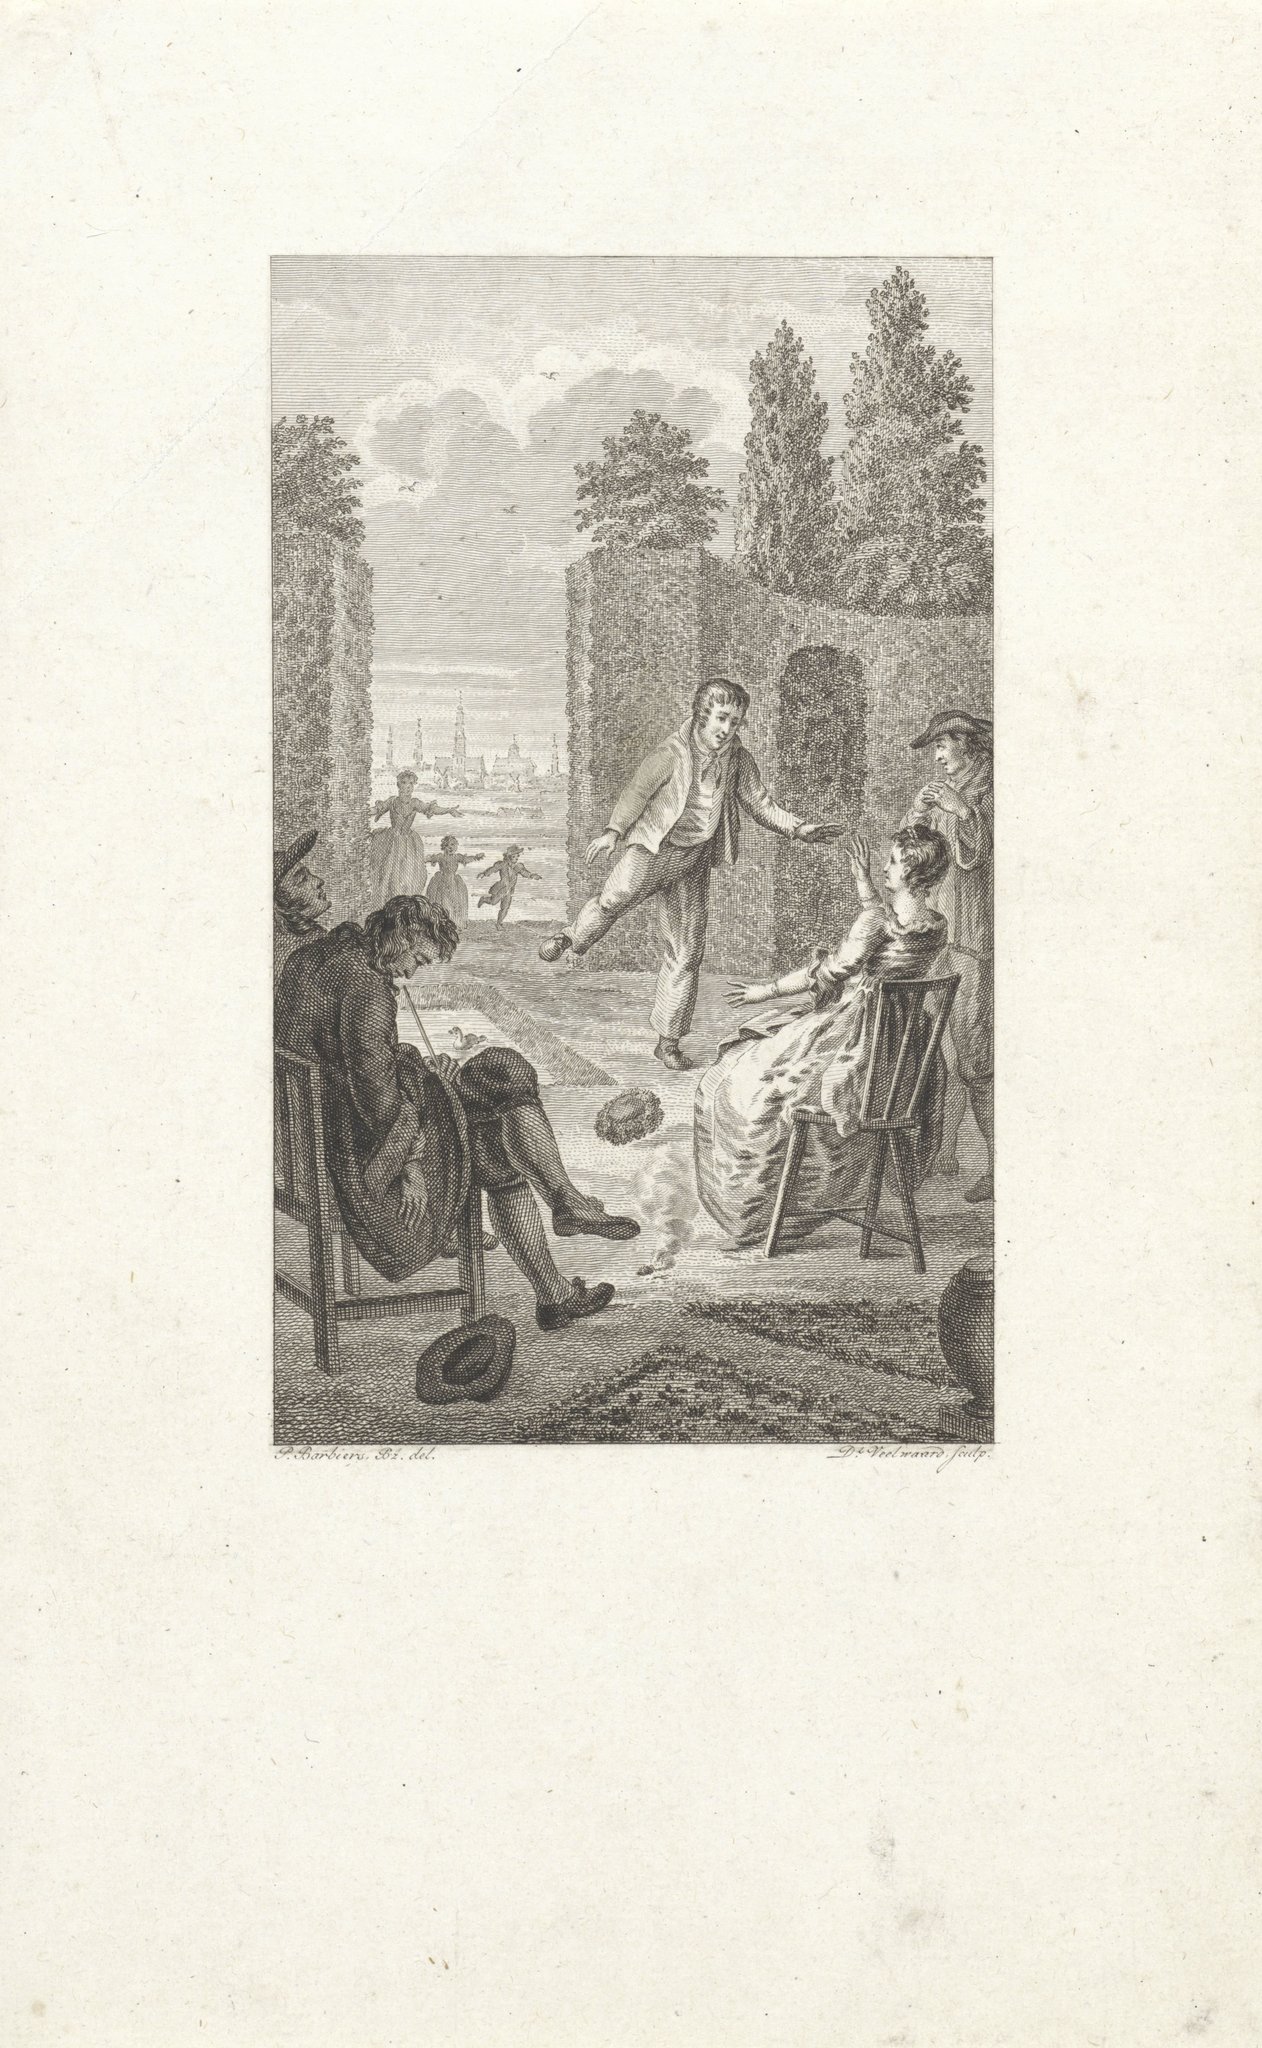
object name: print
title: Verschillende figuren in een tuin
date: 1776-1851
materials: paper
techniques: engraving, etching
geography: amsterdam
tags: garden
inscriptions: collector's mark: Lugt 2228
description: Boekillustratie in: Loosjes, Adriaan Pietersz. Het leven van Johannes Wouter Blommesteyn : een Hollandsche familiegeschiedenis uit het begin der achttiende eeuw. Haarlem: Adriaan Loosjes, 1815.